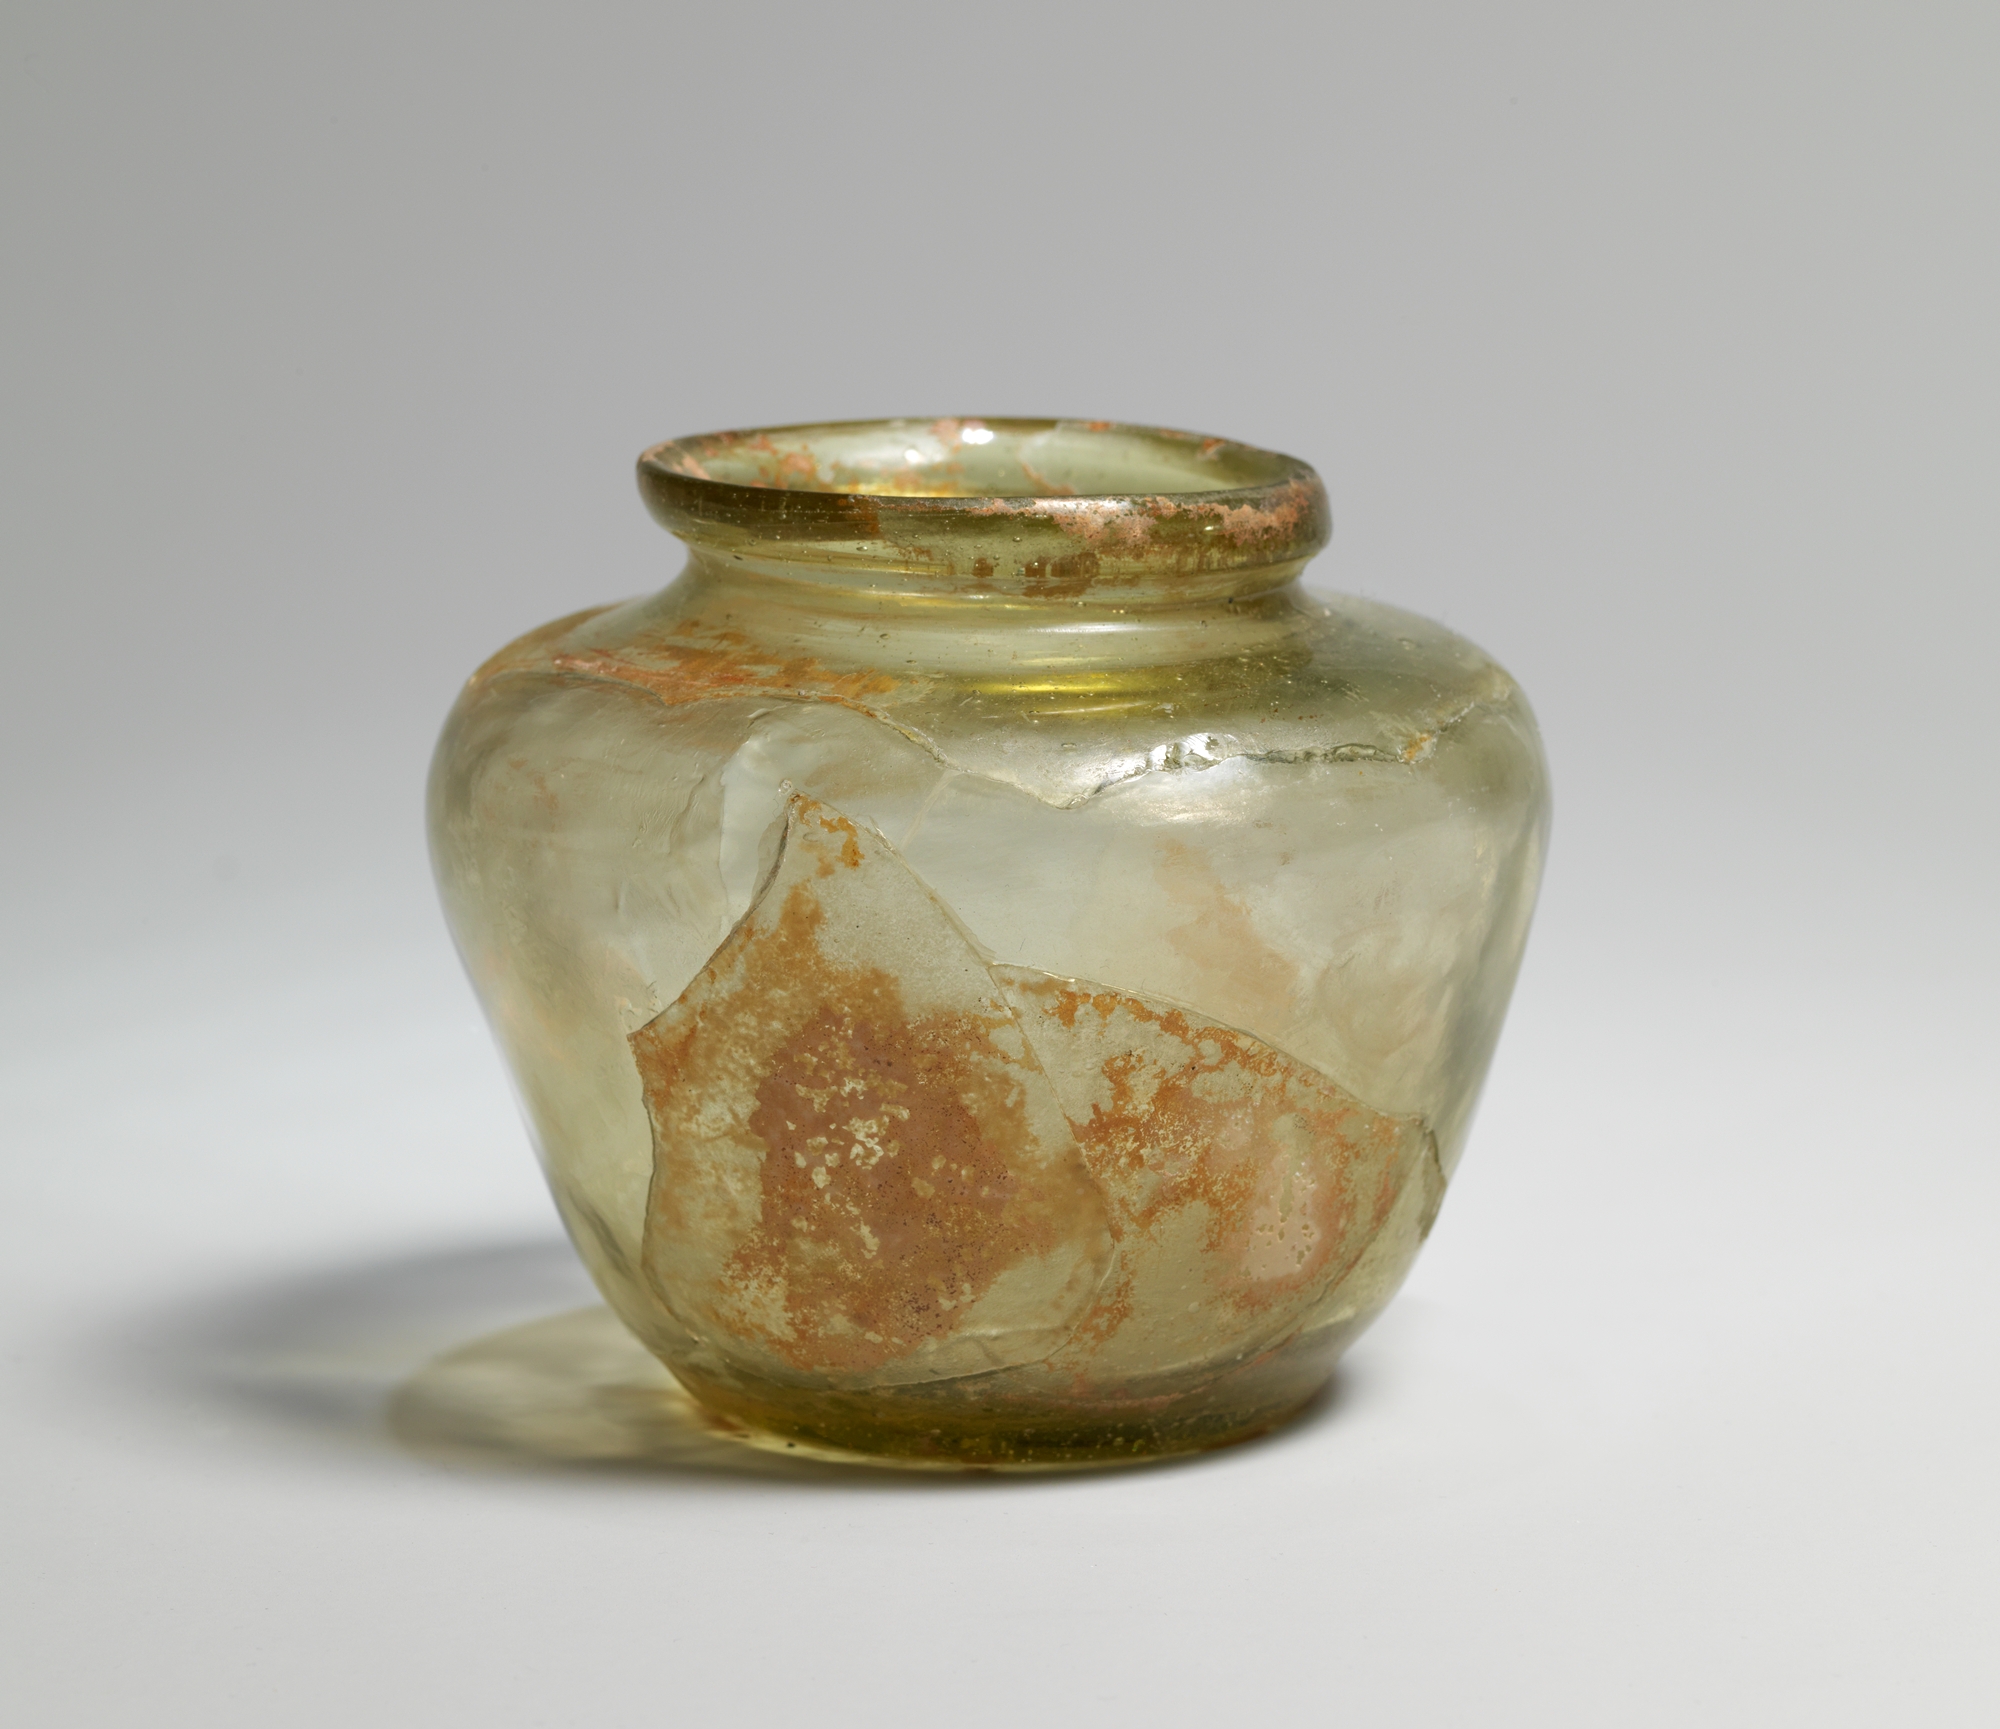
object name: jar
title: Green Glass Jar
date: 901-1000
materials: glass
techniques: glassblowing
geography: iran